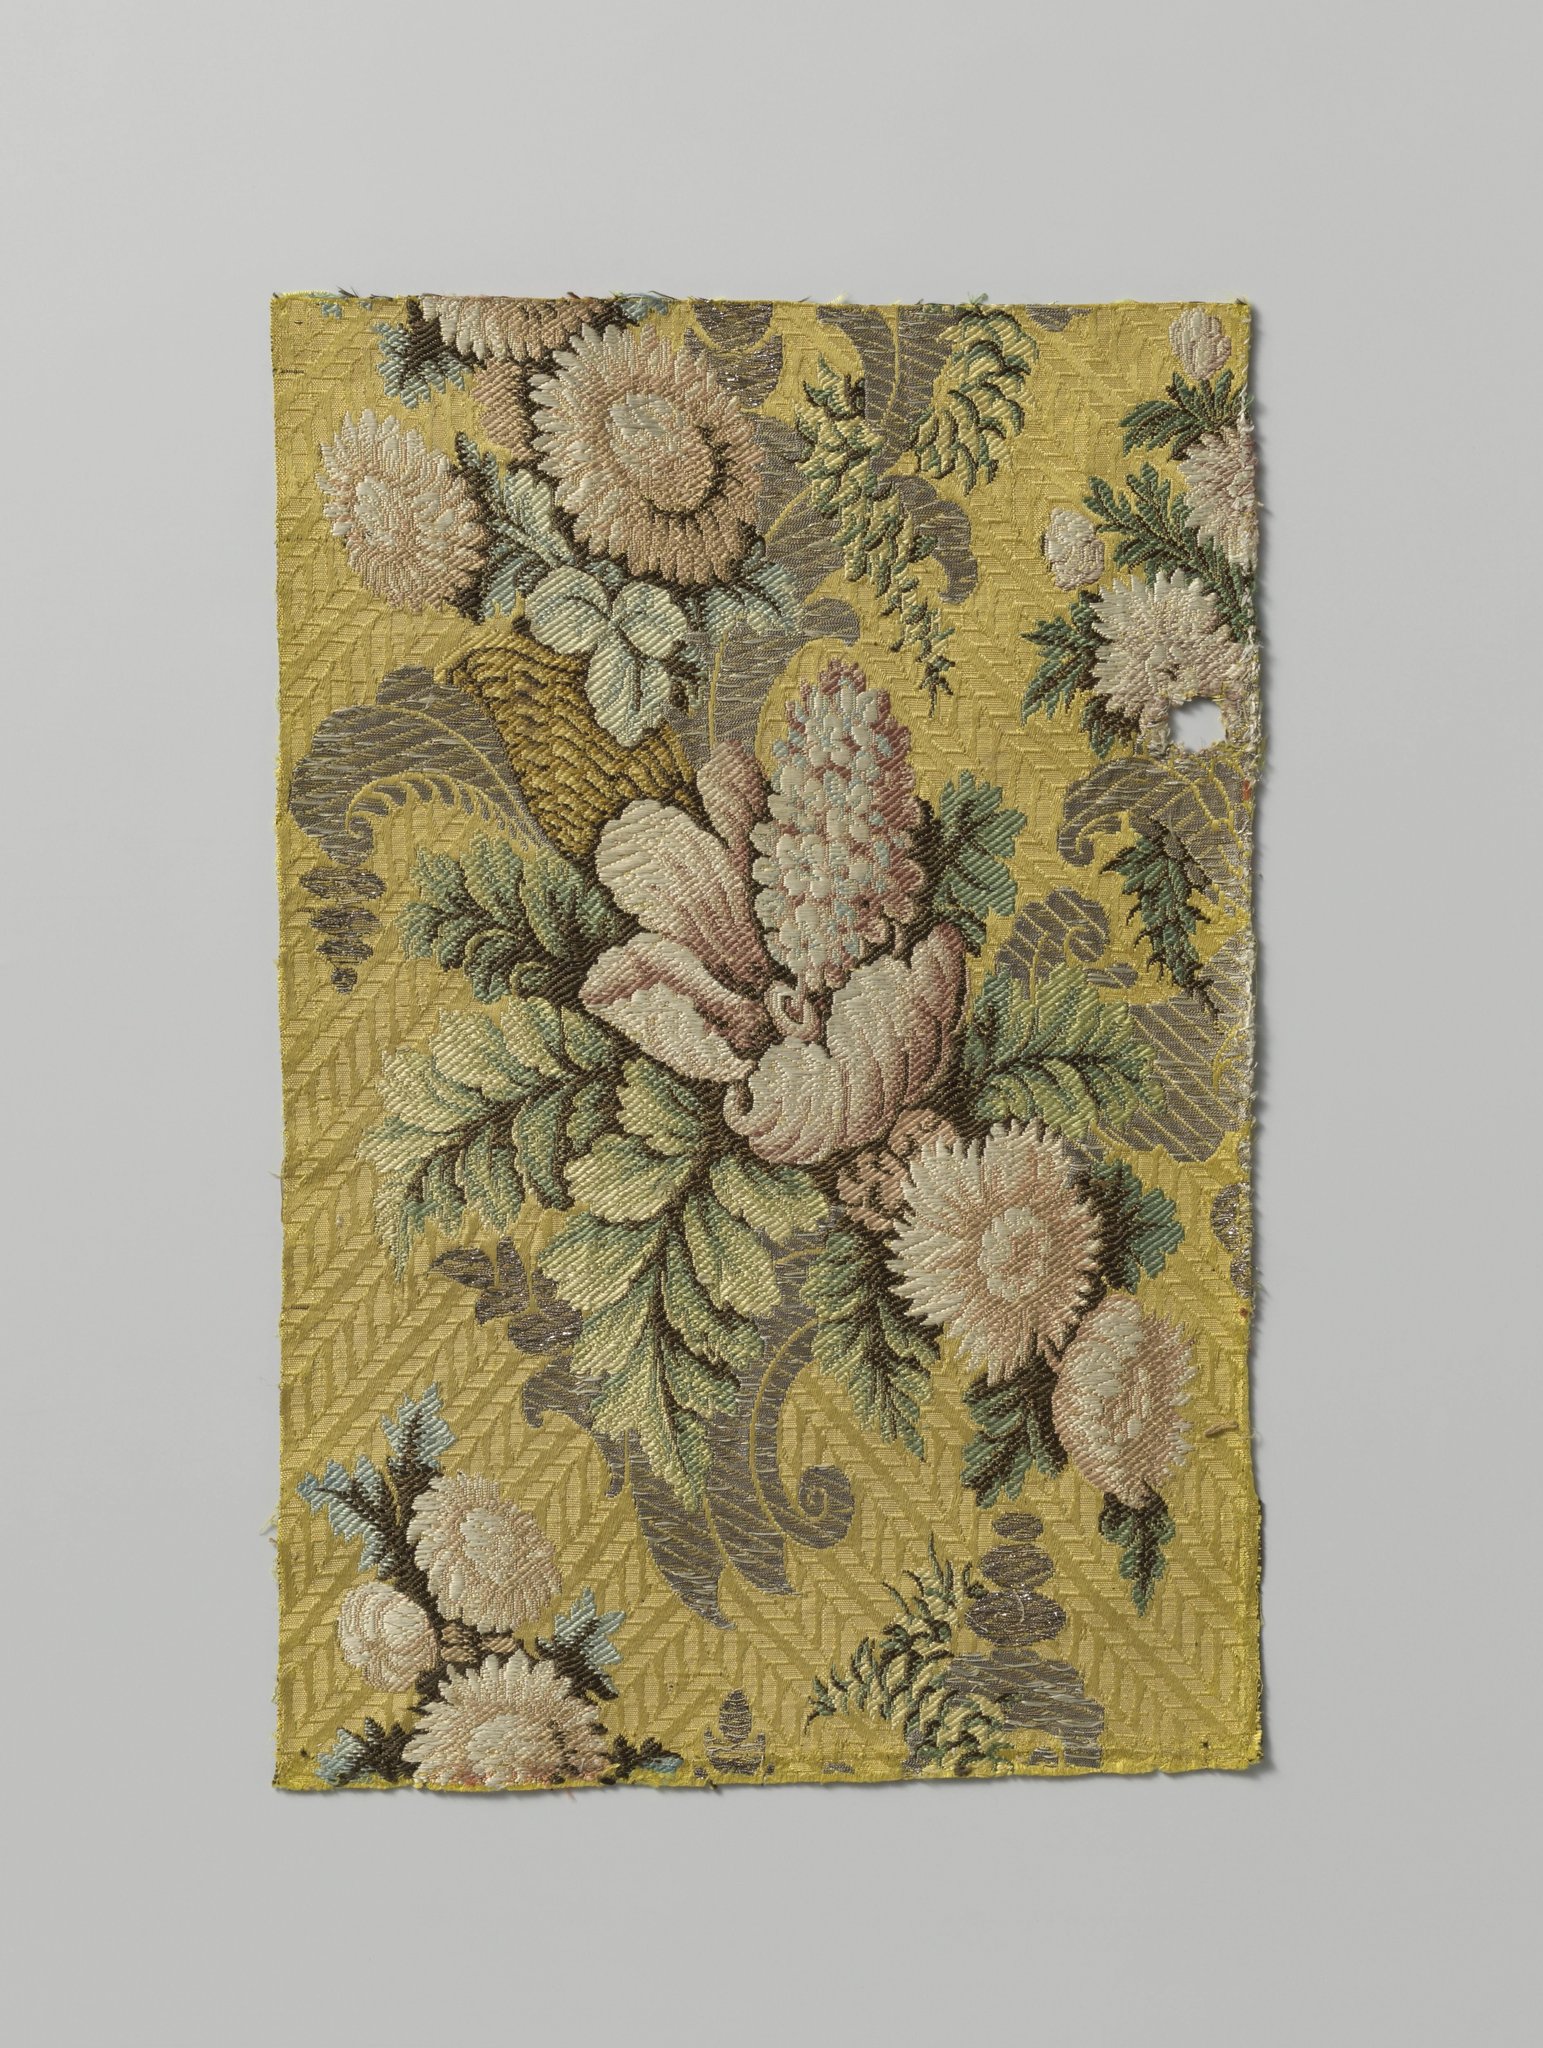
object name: fragment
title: Fragment gebrocheerde gele zijde met veelkleurig patroon van boeketten van onder meer papavers, hyacinthen, asters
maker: Anonymous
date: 1740-1760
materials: silk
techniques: brocade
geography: lyon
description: Fragment gele zijde met veelkleurig patroon in zilver, wit, rood, paars, bruin en blauw van boeketten van papavers, hyacinthen, asters etc., omgeven door bladwerk. Object is samengesteld uit twee aan elkaar genaaide fragmenten.